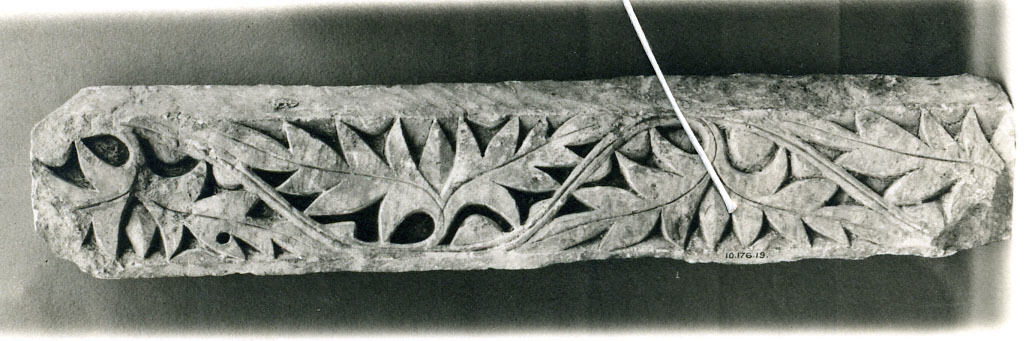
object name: block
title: Fragment from a Post or Lintel with Leaves Branching from a Running Vine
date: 501-700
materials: limestone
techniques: carving, relief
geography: egypt